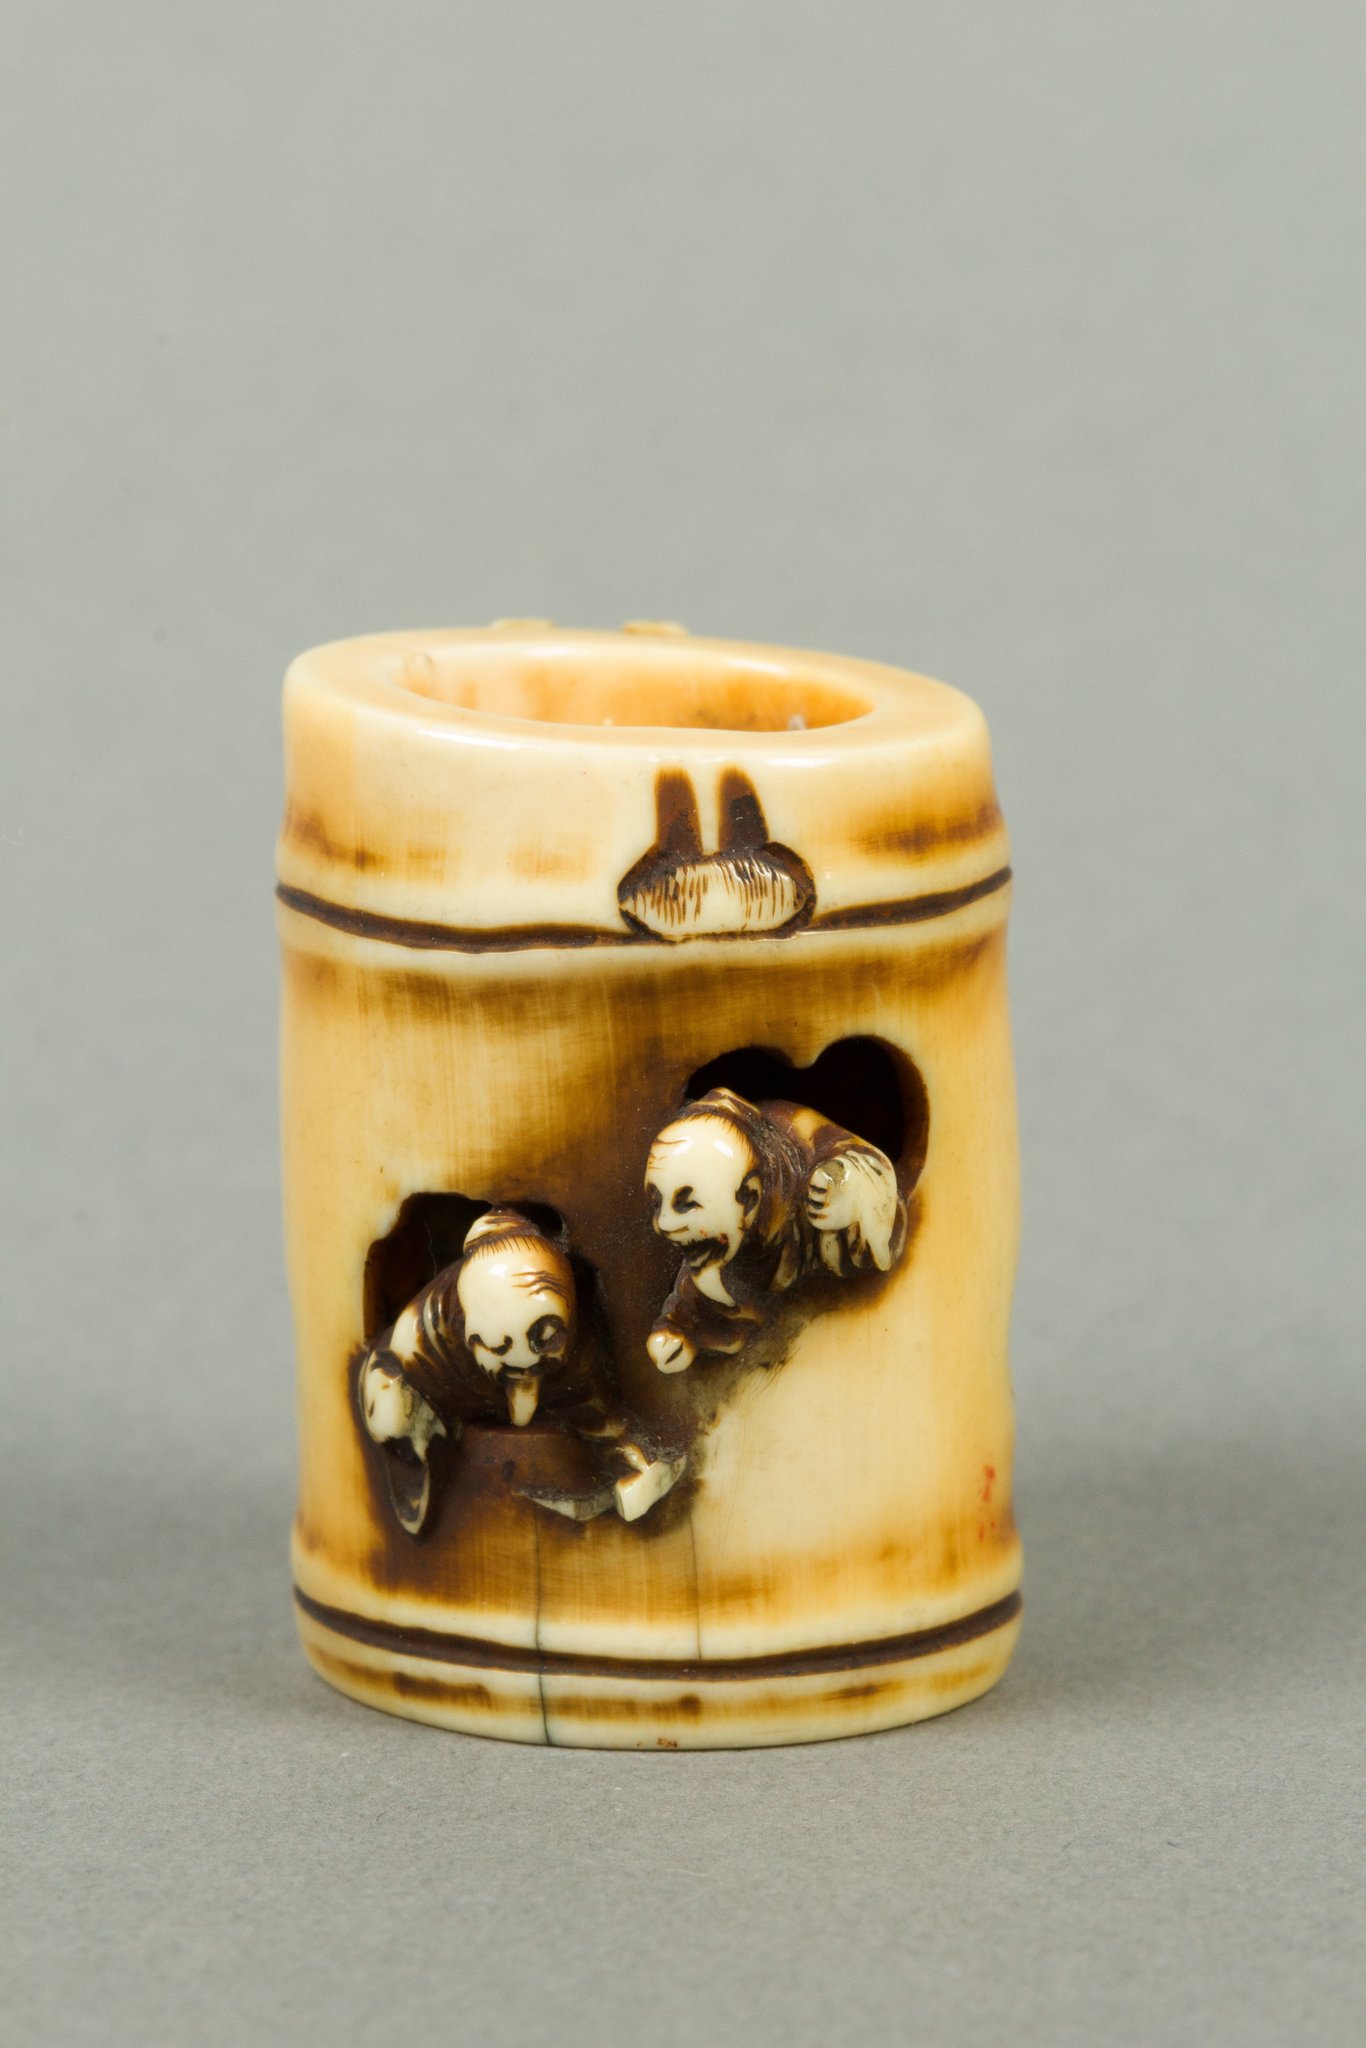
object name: netsuke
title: Netsuke of Section of Bamboo Containing Two Men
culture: japanese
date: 1801-1900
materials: ivory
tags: men